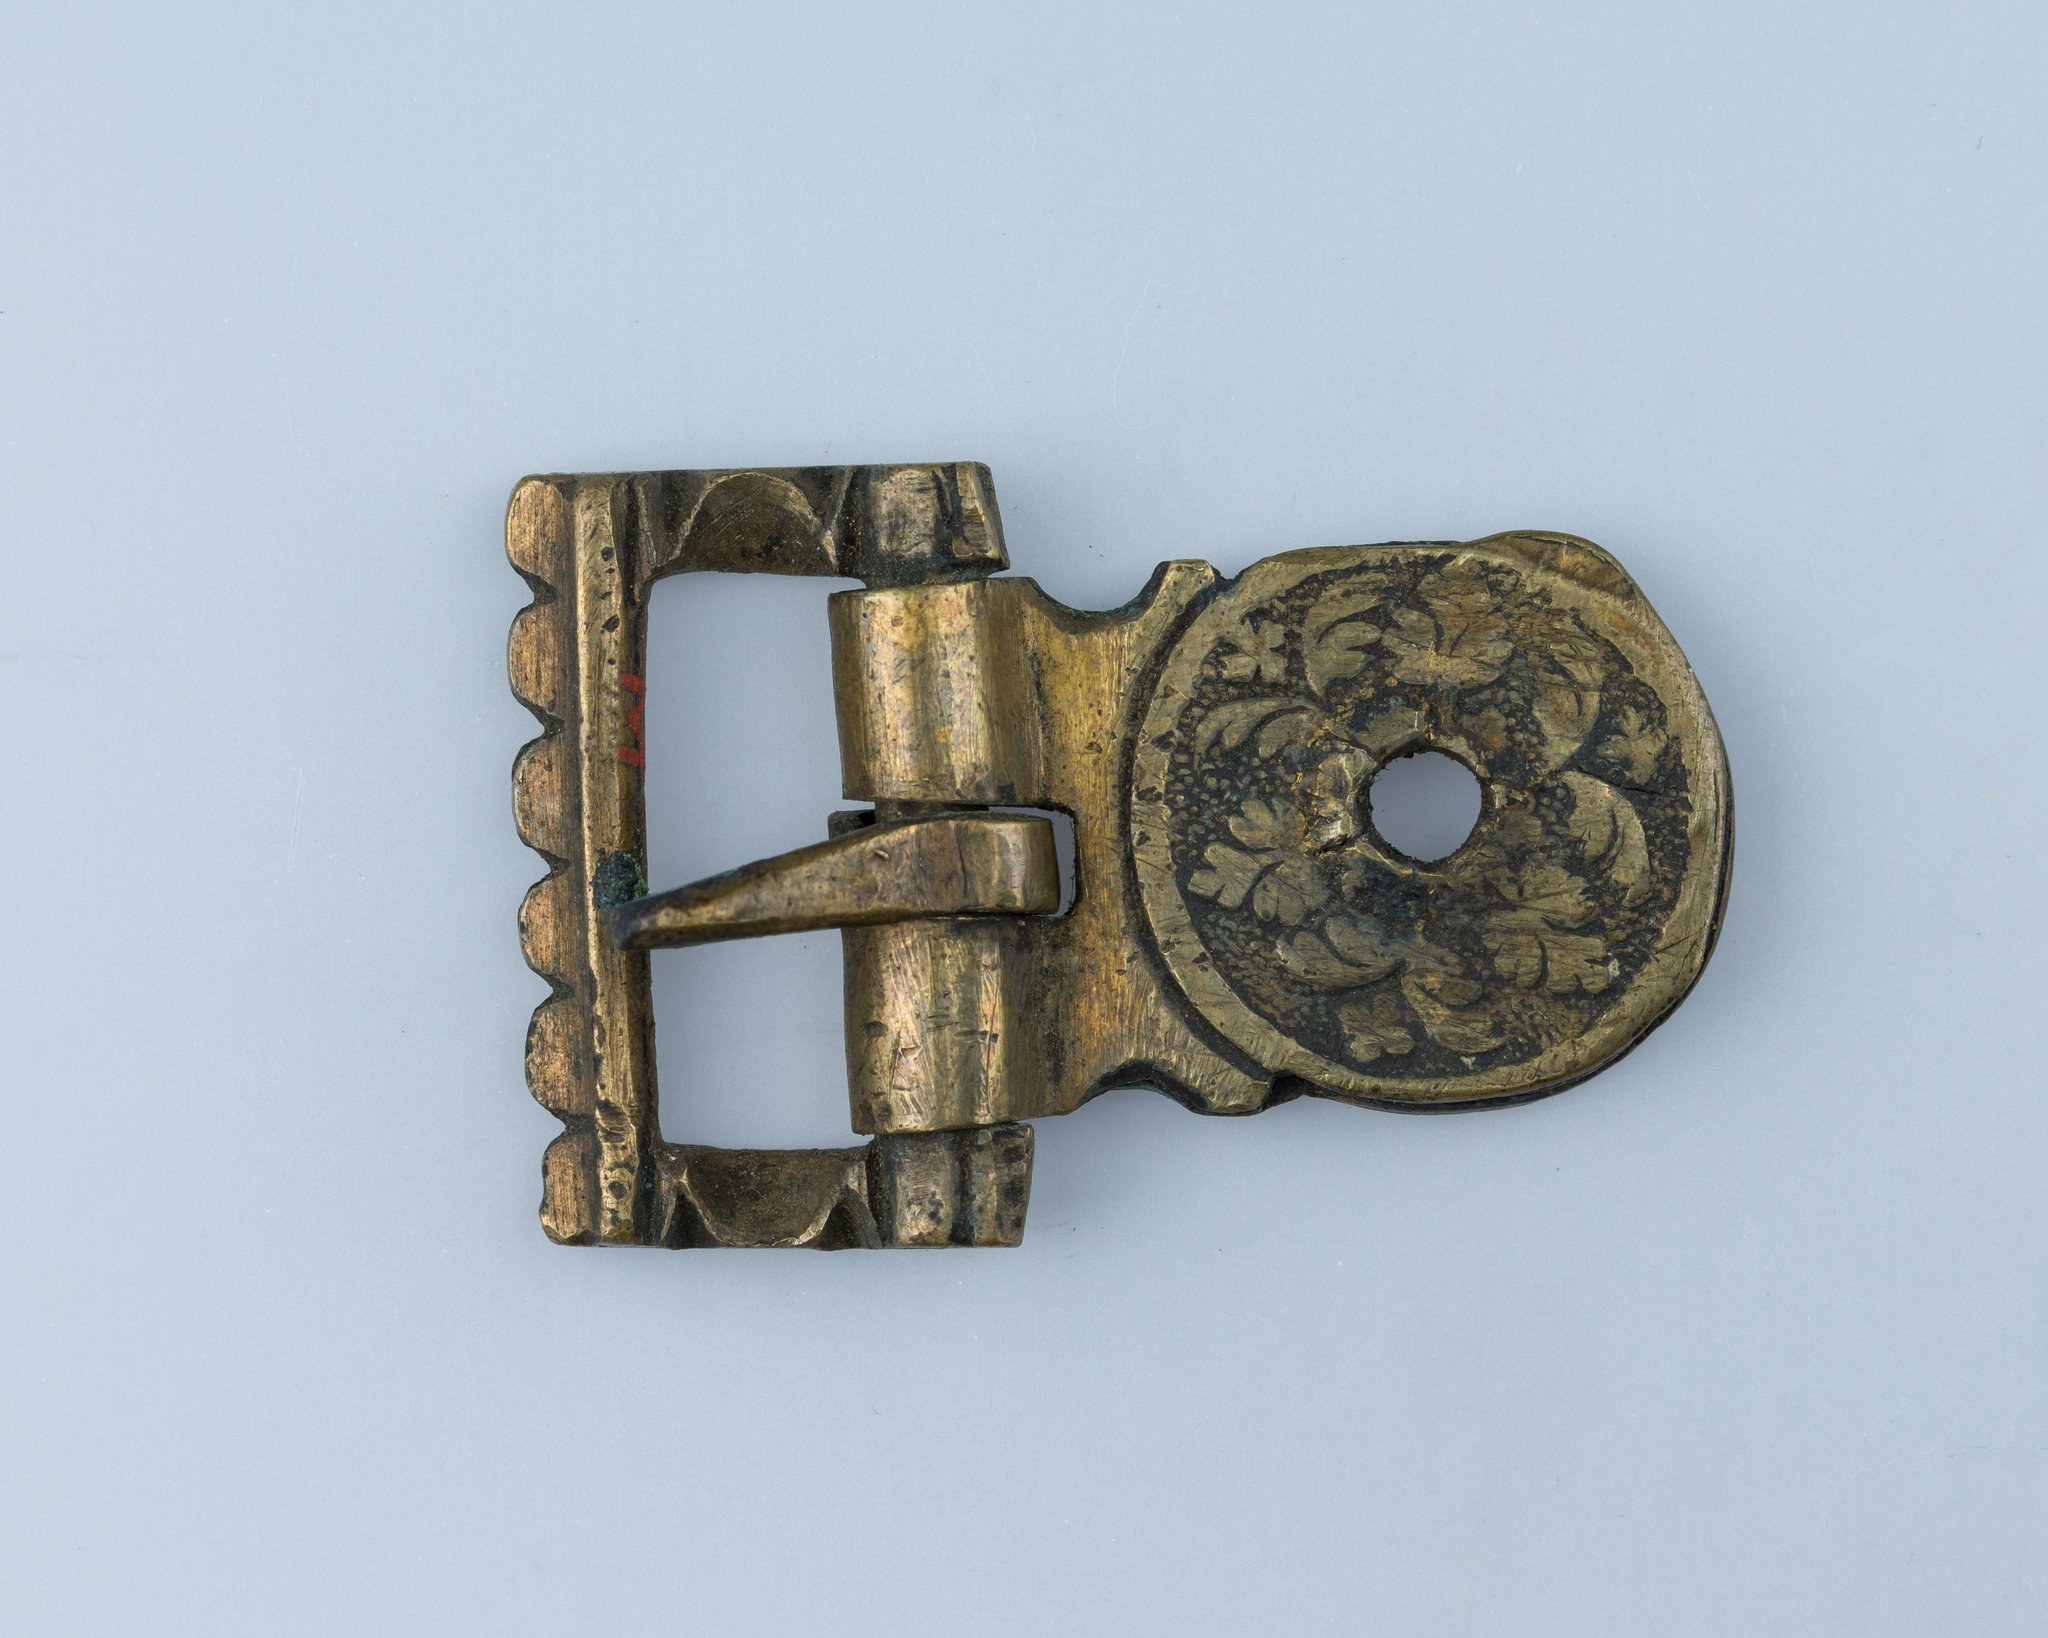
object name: buckle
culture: german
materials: brass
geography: germany